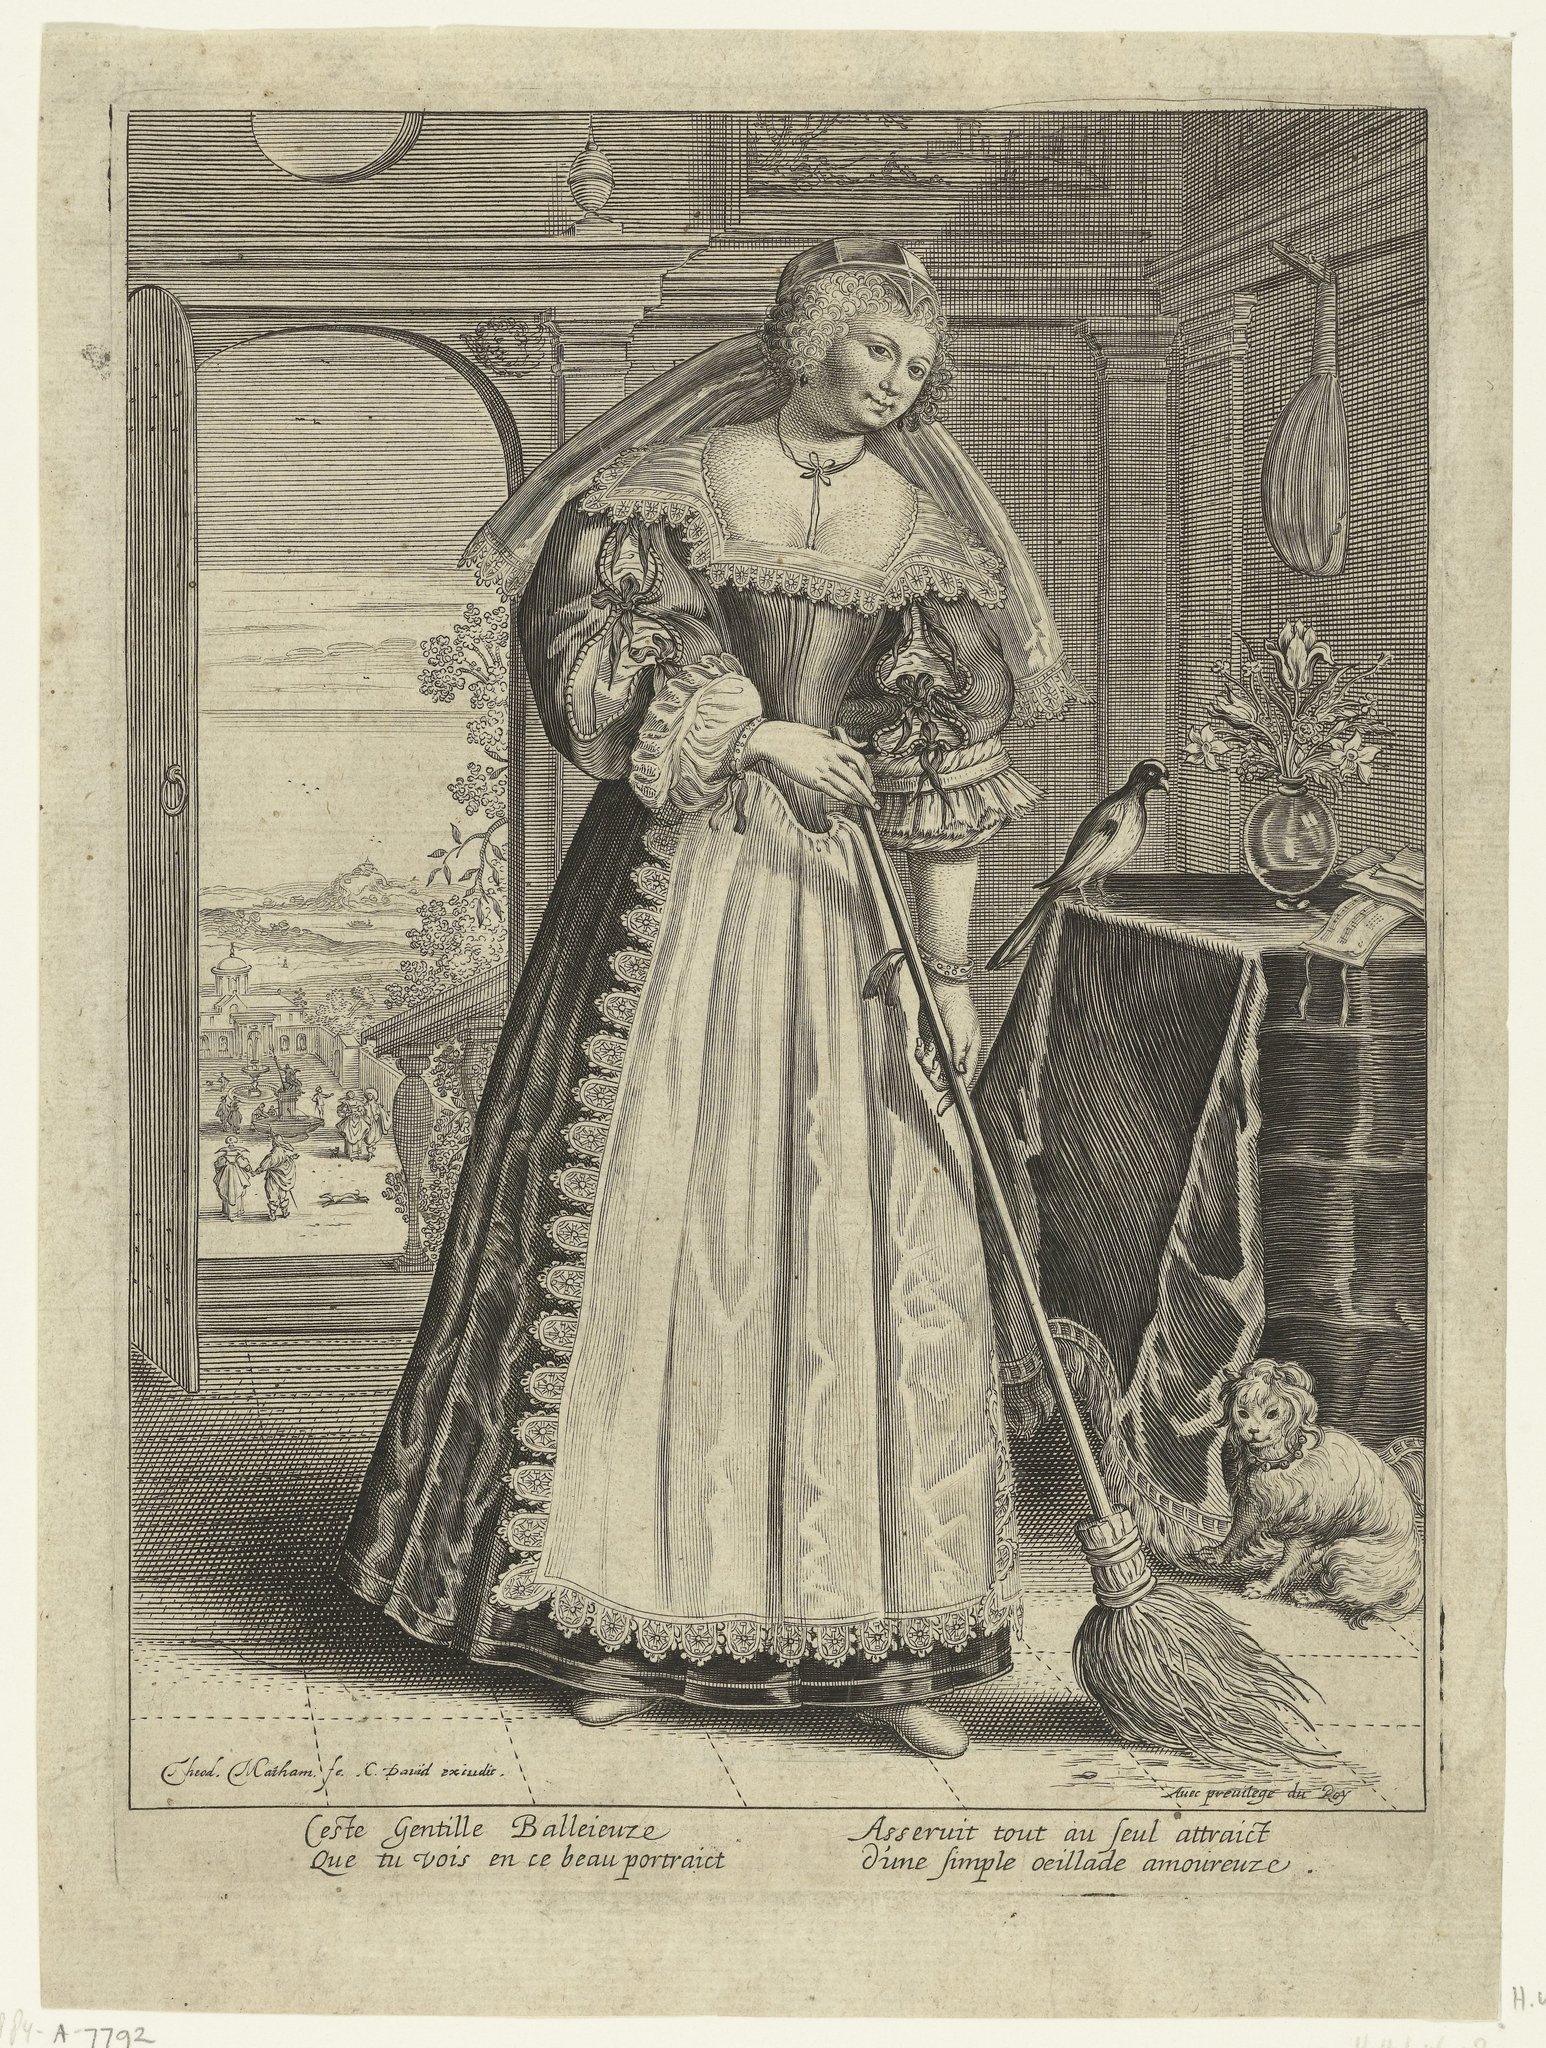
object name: print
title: Drie dames staand ten voeten uit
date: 1627-1629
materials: paper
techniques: engraving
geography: paris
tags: dress, gown (+ women's clothes), interior of the house, lute, and special forms of lute, e.g.: theorbo, (household) utensils and implements, dog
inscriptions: privilege: ‘Avec Privilege du Roy’, signature and date: ‘Theod. Matham fe.’, address: ‘C. David excudit’, collector's mark: Lugt 2228, inscription: ‘1e staat met adres van David. 2e bij Schneevoogt met adres van le Blond.’, caption: ‘Cette Gentille Balleieuze...d'une simple oeillade amoureuze’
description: Elegant geklede vrouw die met een bezem de vloer aanveegt. Rechts een tafel waarop een vaas bloemen en een vogel. Aan de muur hangt een luit. Voor de tafel een hondje. Door de deuropening gezicht naar buiten. De dame is gekleed in japon met decolleté met kanten kraag. Haar schort is eveneens afgezet met kant. Op het hoofd een mutsje dat in een sluier uitloopt.